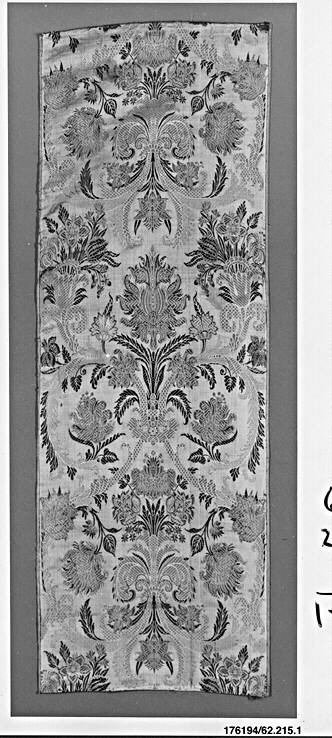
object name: piece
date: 1730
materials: silk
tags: flowers,leaves